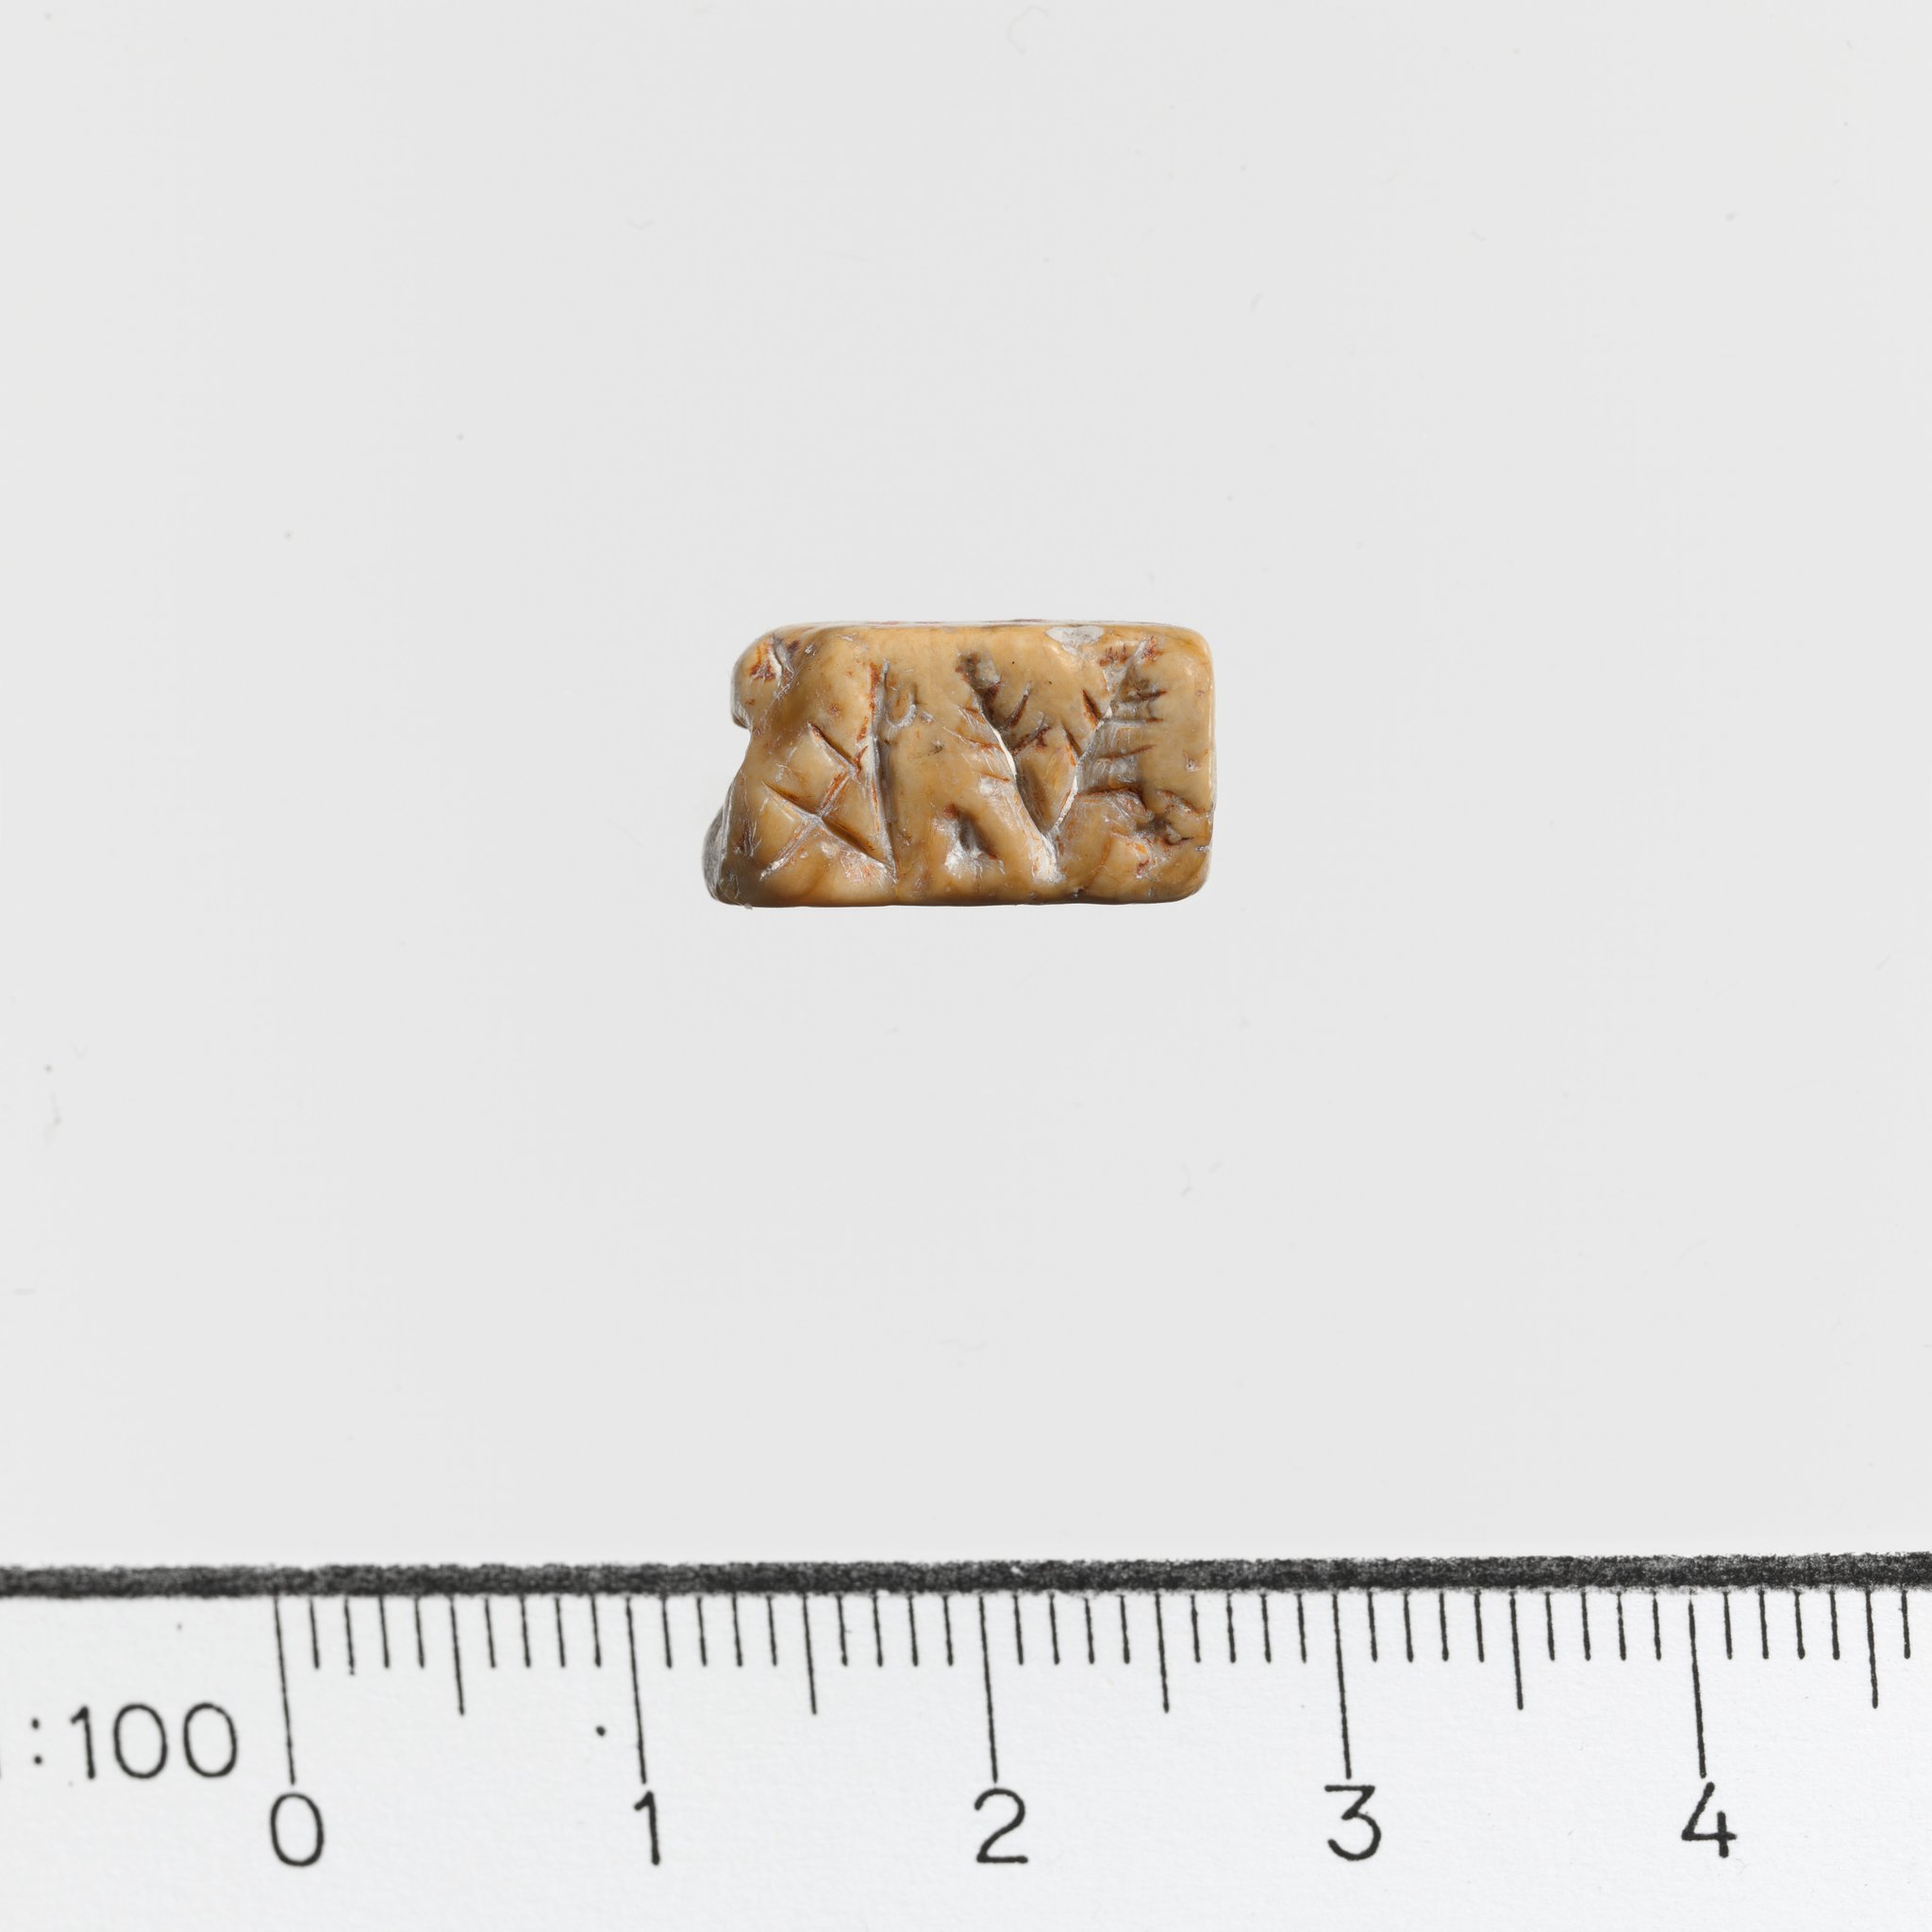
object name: seal with hole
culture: minoan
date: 2600-2000 BCE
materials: stone